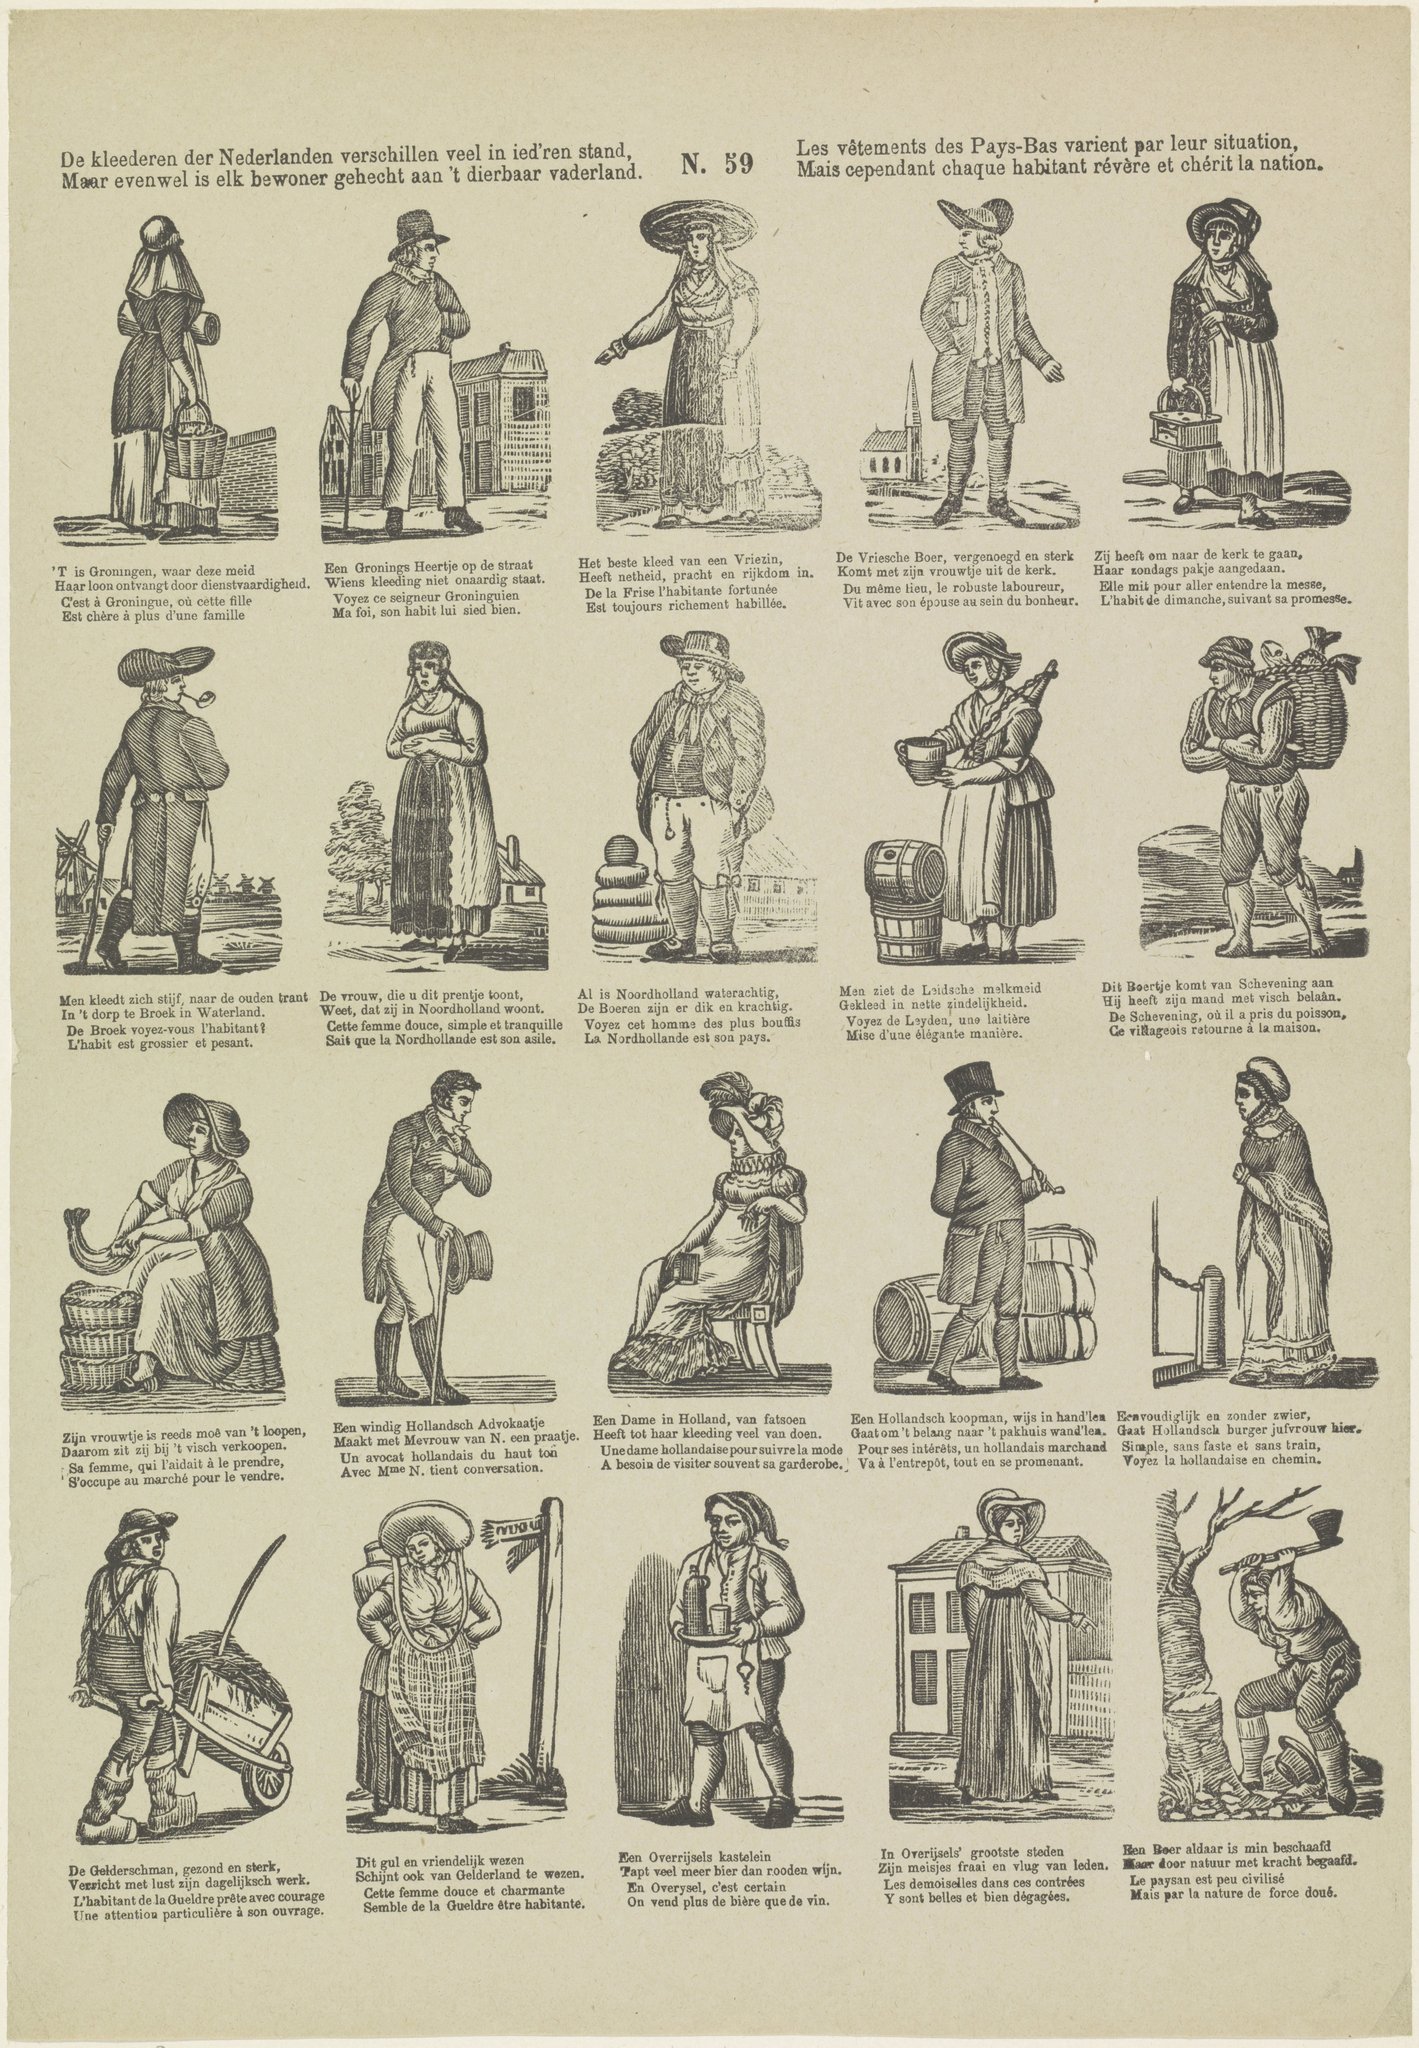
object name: print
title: De kleederen der Nederlanden verschillen veel in ied'ren stand, / Maar even wel is elk bewoner gehecht aan 't dierbaar vaderland / Les vêtements des pays-Bas varient par leur situation, / Mais cependant chaque habitant révère et chérit la nation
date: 1800-1833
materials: paper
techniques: letterpress printing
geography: turnhout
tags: historical costume, folk costume, regional costume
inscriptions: collector's mark: Lugt 2760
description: Blad met 20 voorstellingen van personen in verschillende Nederlandse klederdrachten. Onder elke afbeelding een tweeregelig vers in het Nederlands en in het Frans. Genummerd midden boven: N. 59.